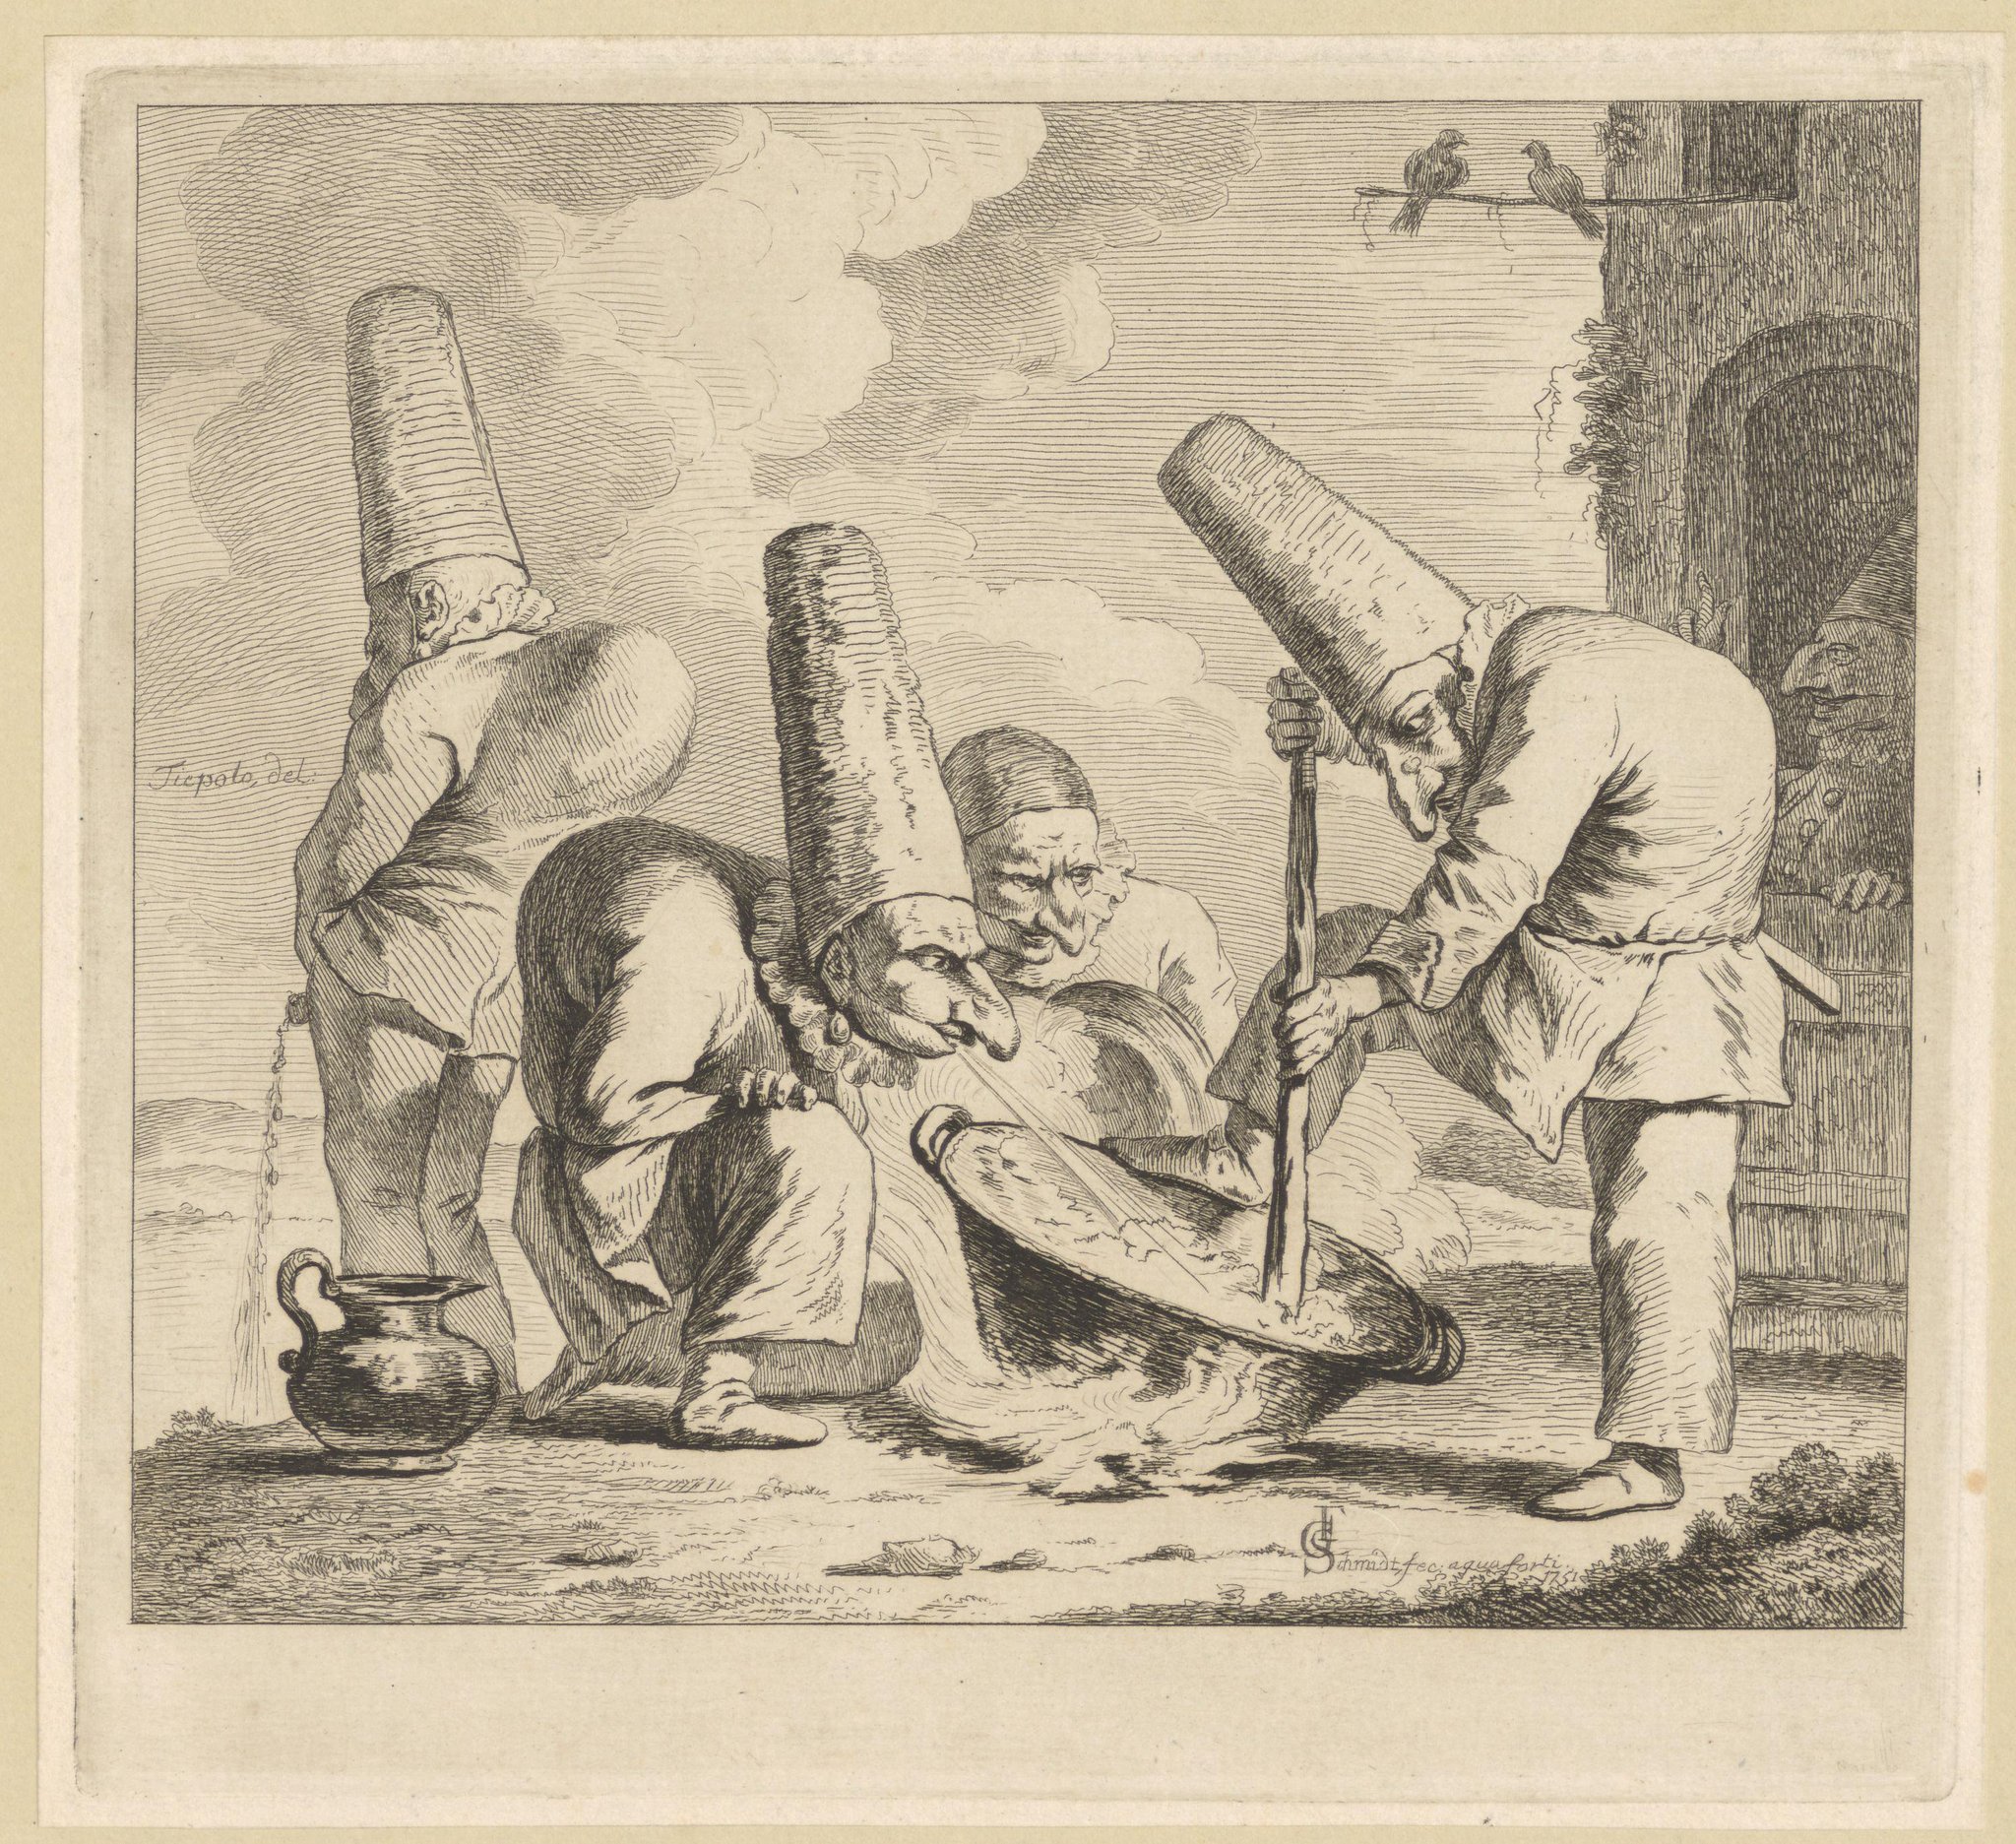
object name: print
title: Vijf gebochelde potsenmakers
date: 1751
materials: paper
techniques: etching, intaglio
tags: buffoon (in general) (german: 'schalksnarr'), urination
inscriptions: collector's mark: Lugt 240